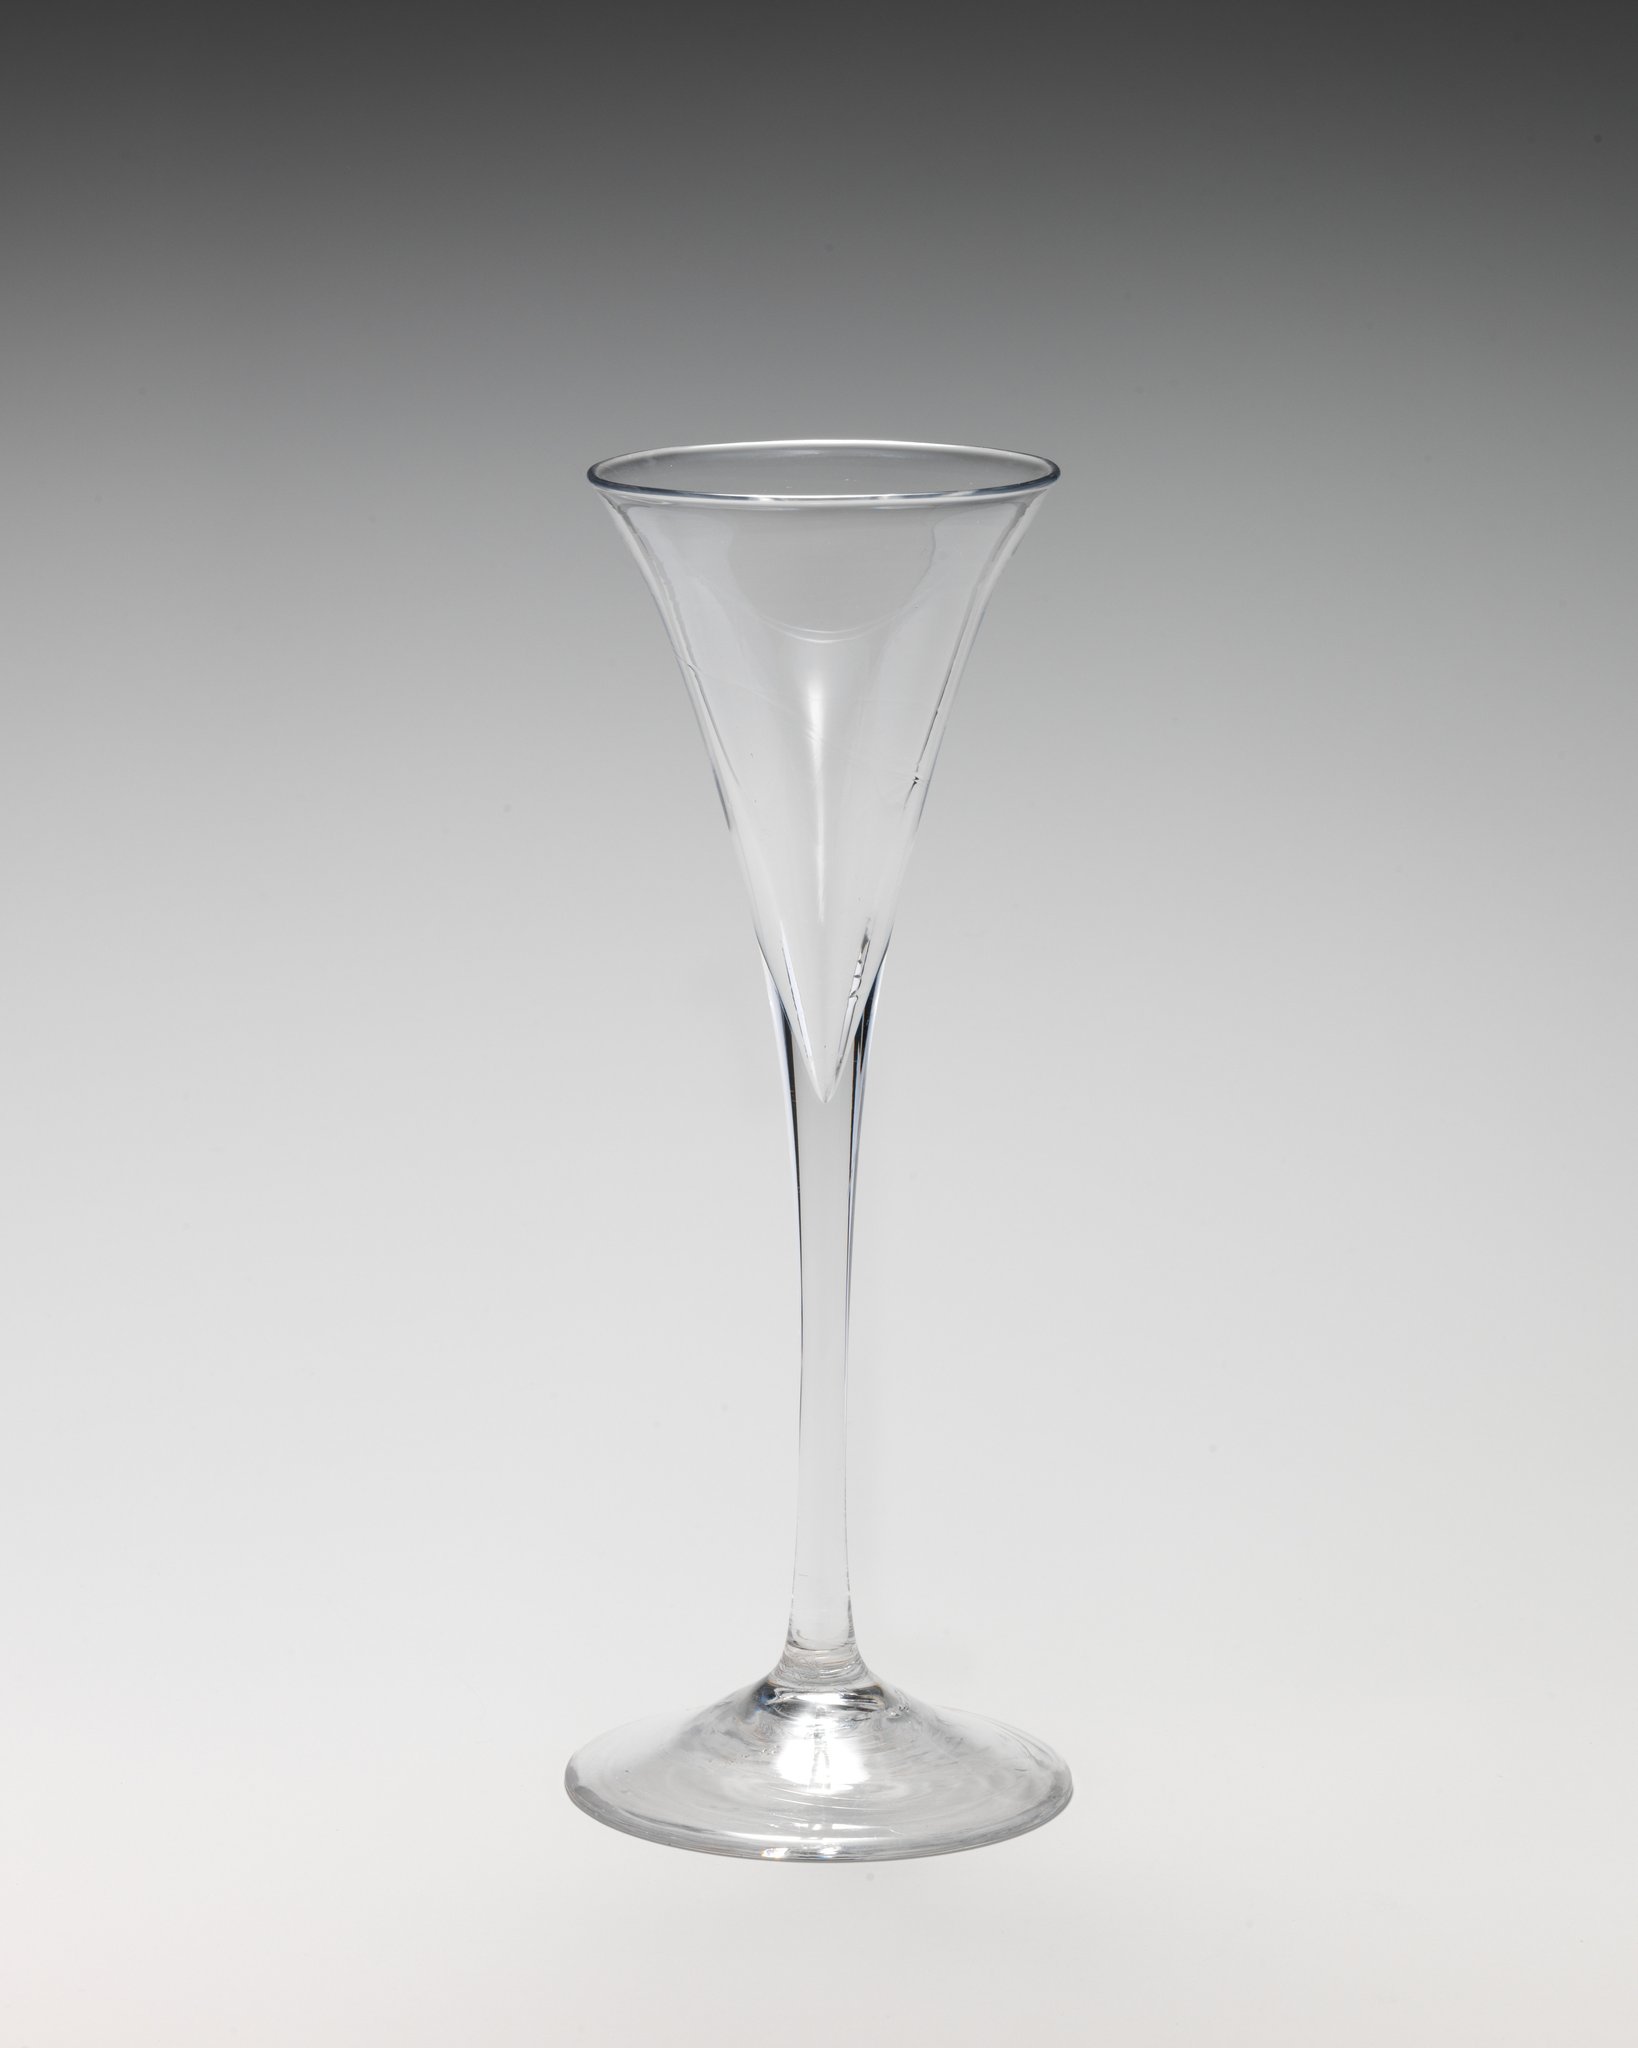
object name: wineglass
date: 1740-1800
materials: glass